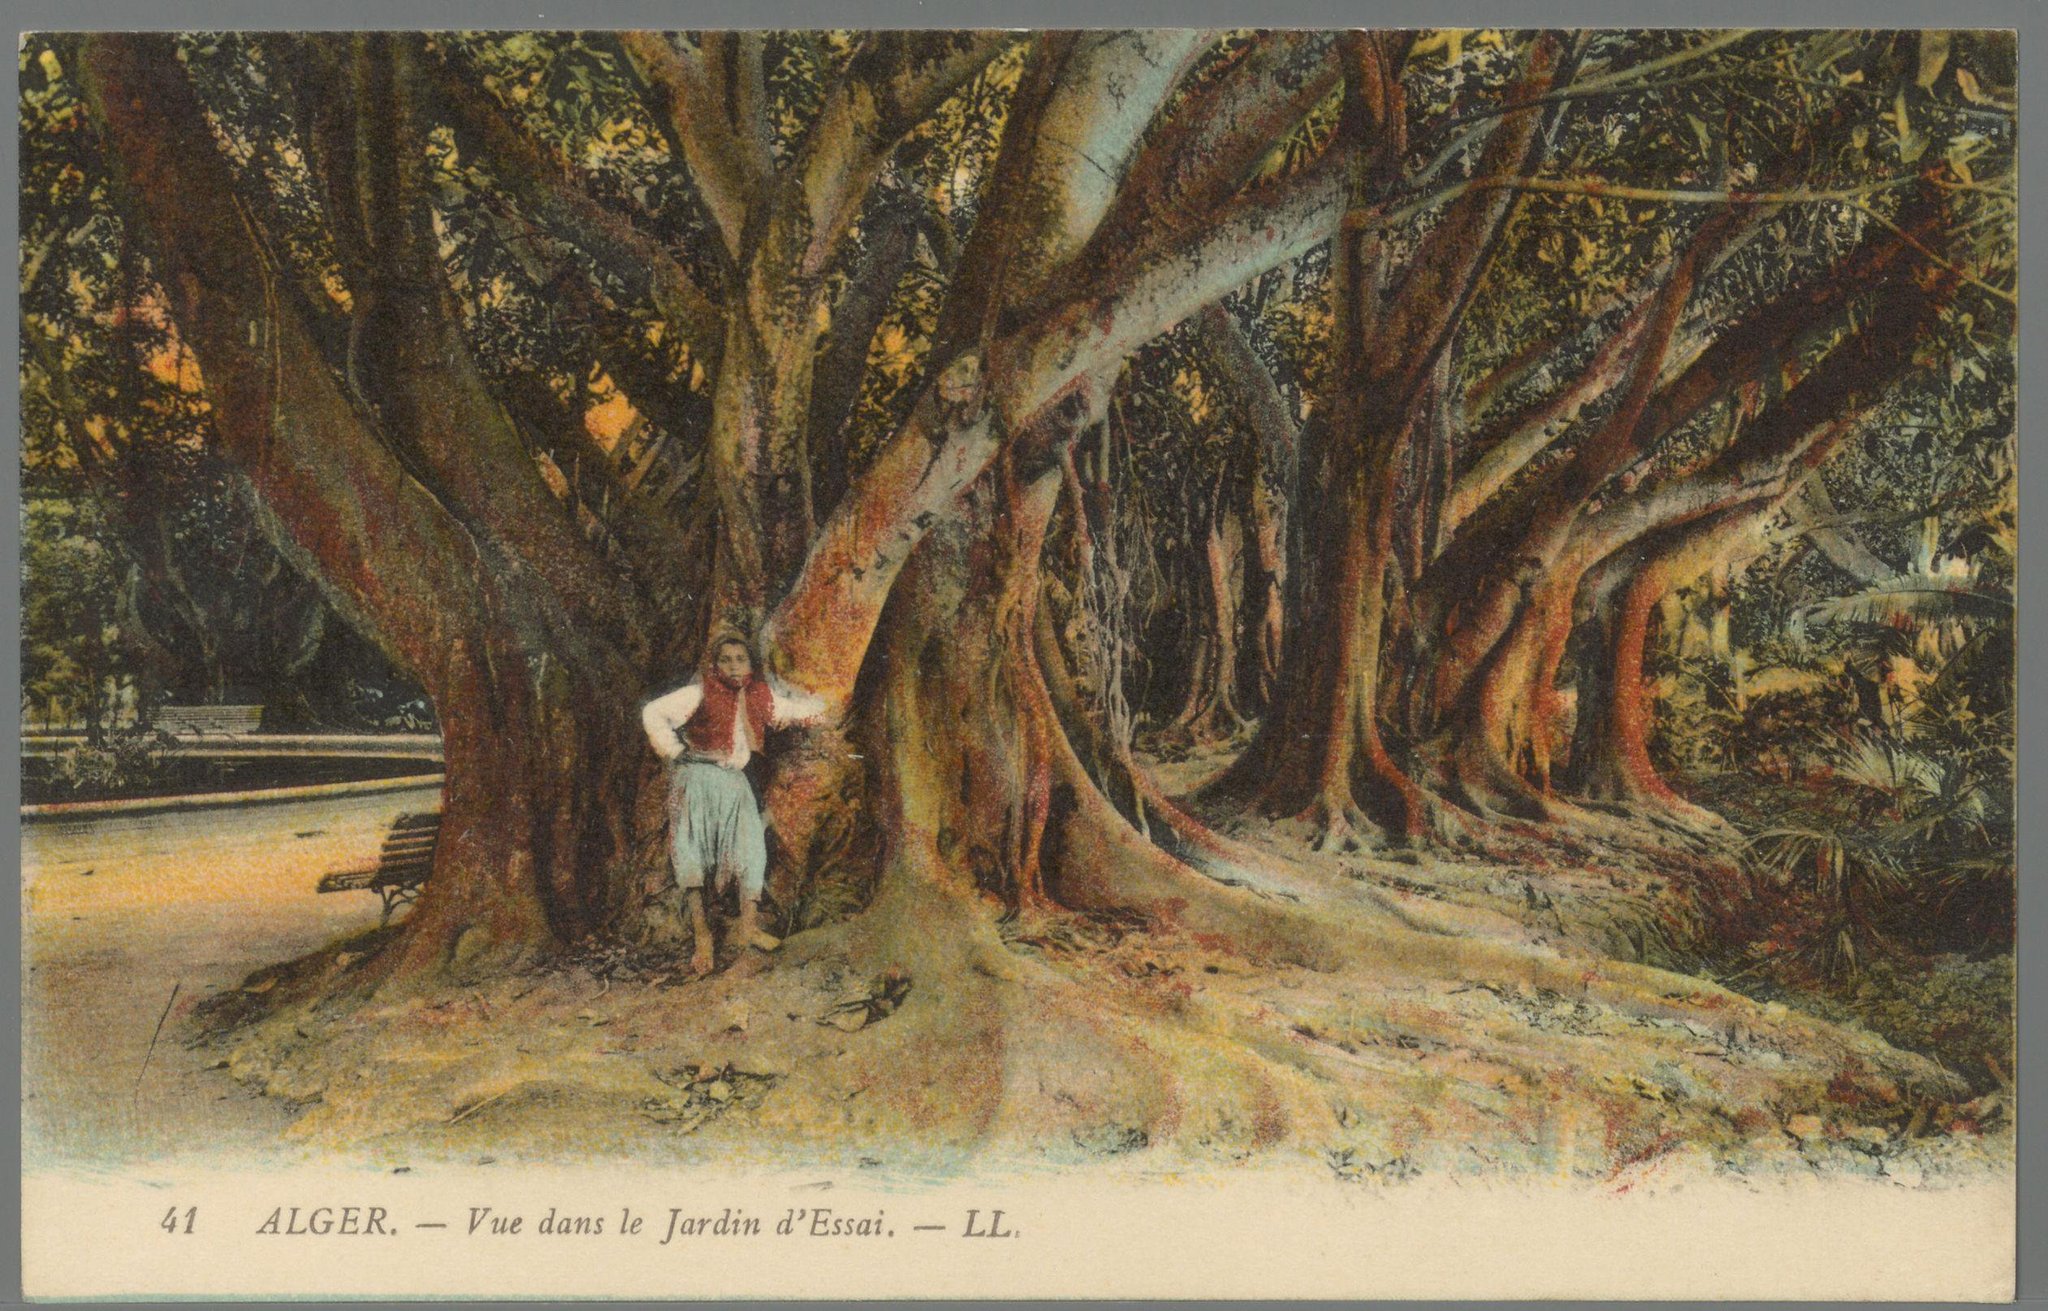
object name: photomechanical print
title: Alger. Vue dans le Jardin d'Essai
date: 1903-1920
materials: cardboard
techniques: photograph, lithograph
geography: paris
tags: botanic garden, 'hortus botanicus', public gardens, park, botanical garden hamma